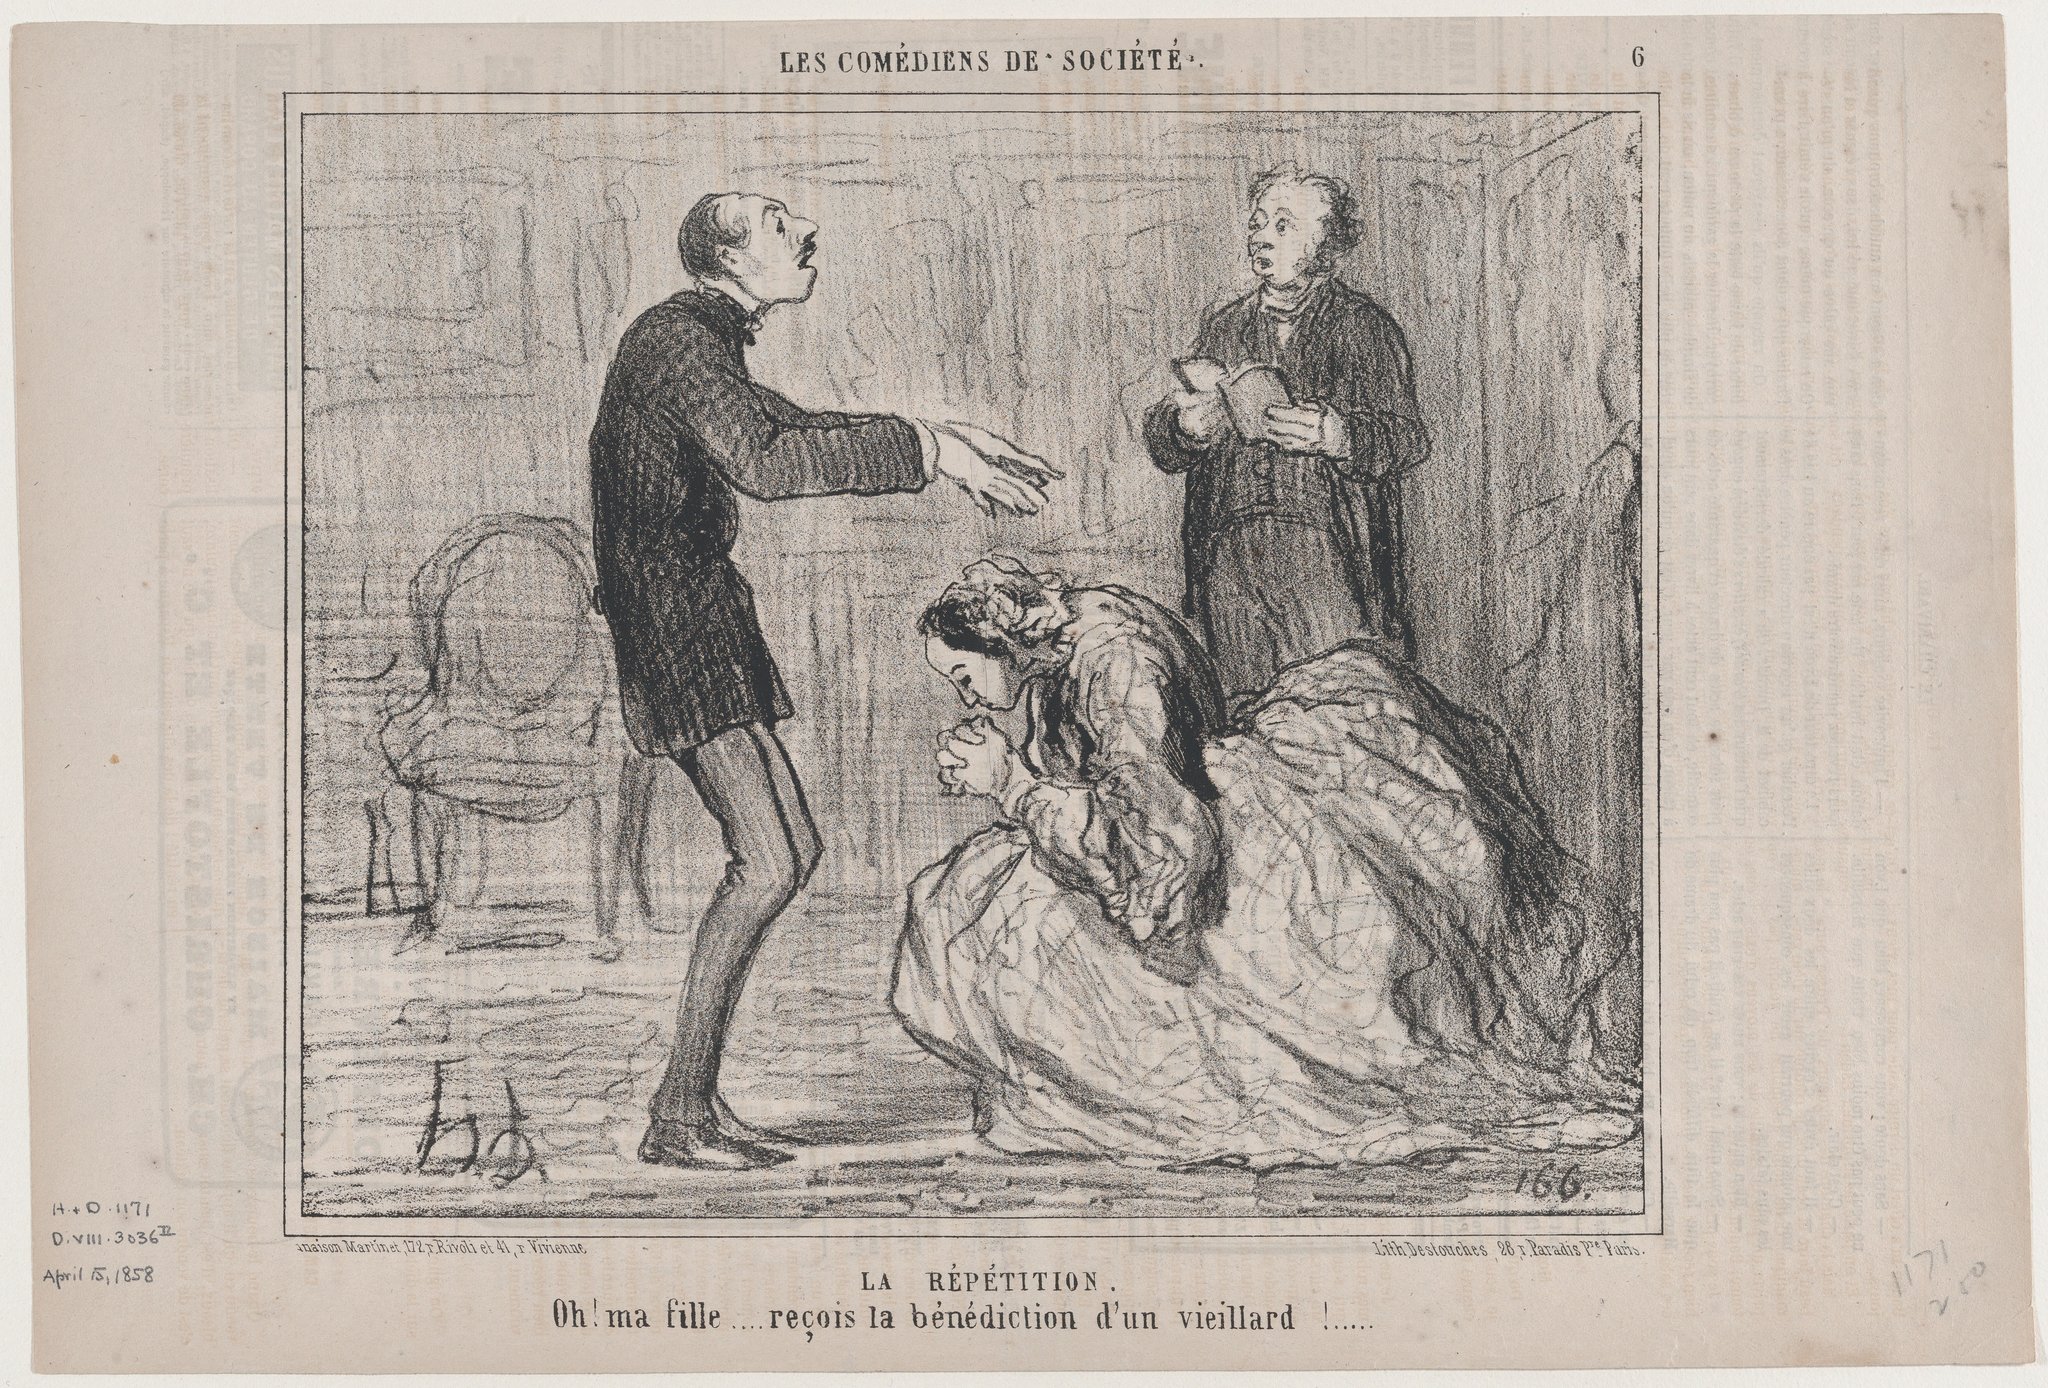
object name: print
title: La Répétition, from "Les Comediens de Société"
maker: honoré daumier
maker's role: artist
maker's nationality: french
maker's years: 1808-1879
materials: paper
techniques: lithograph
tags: men,women